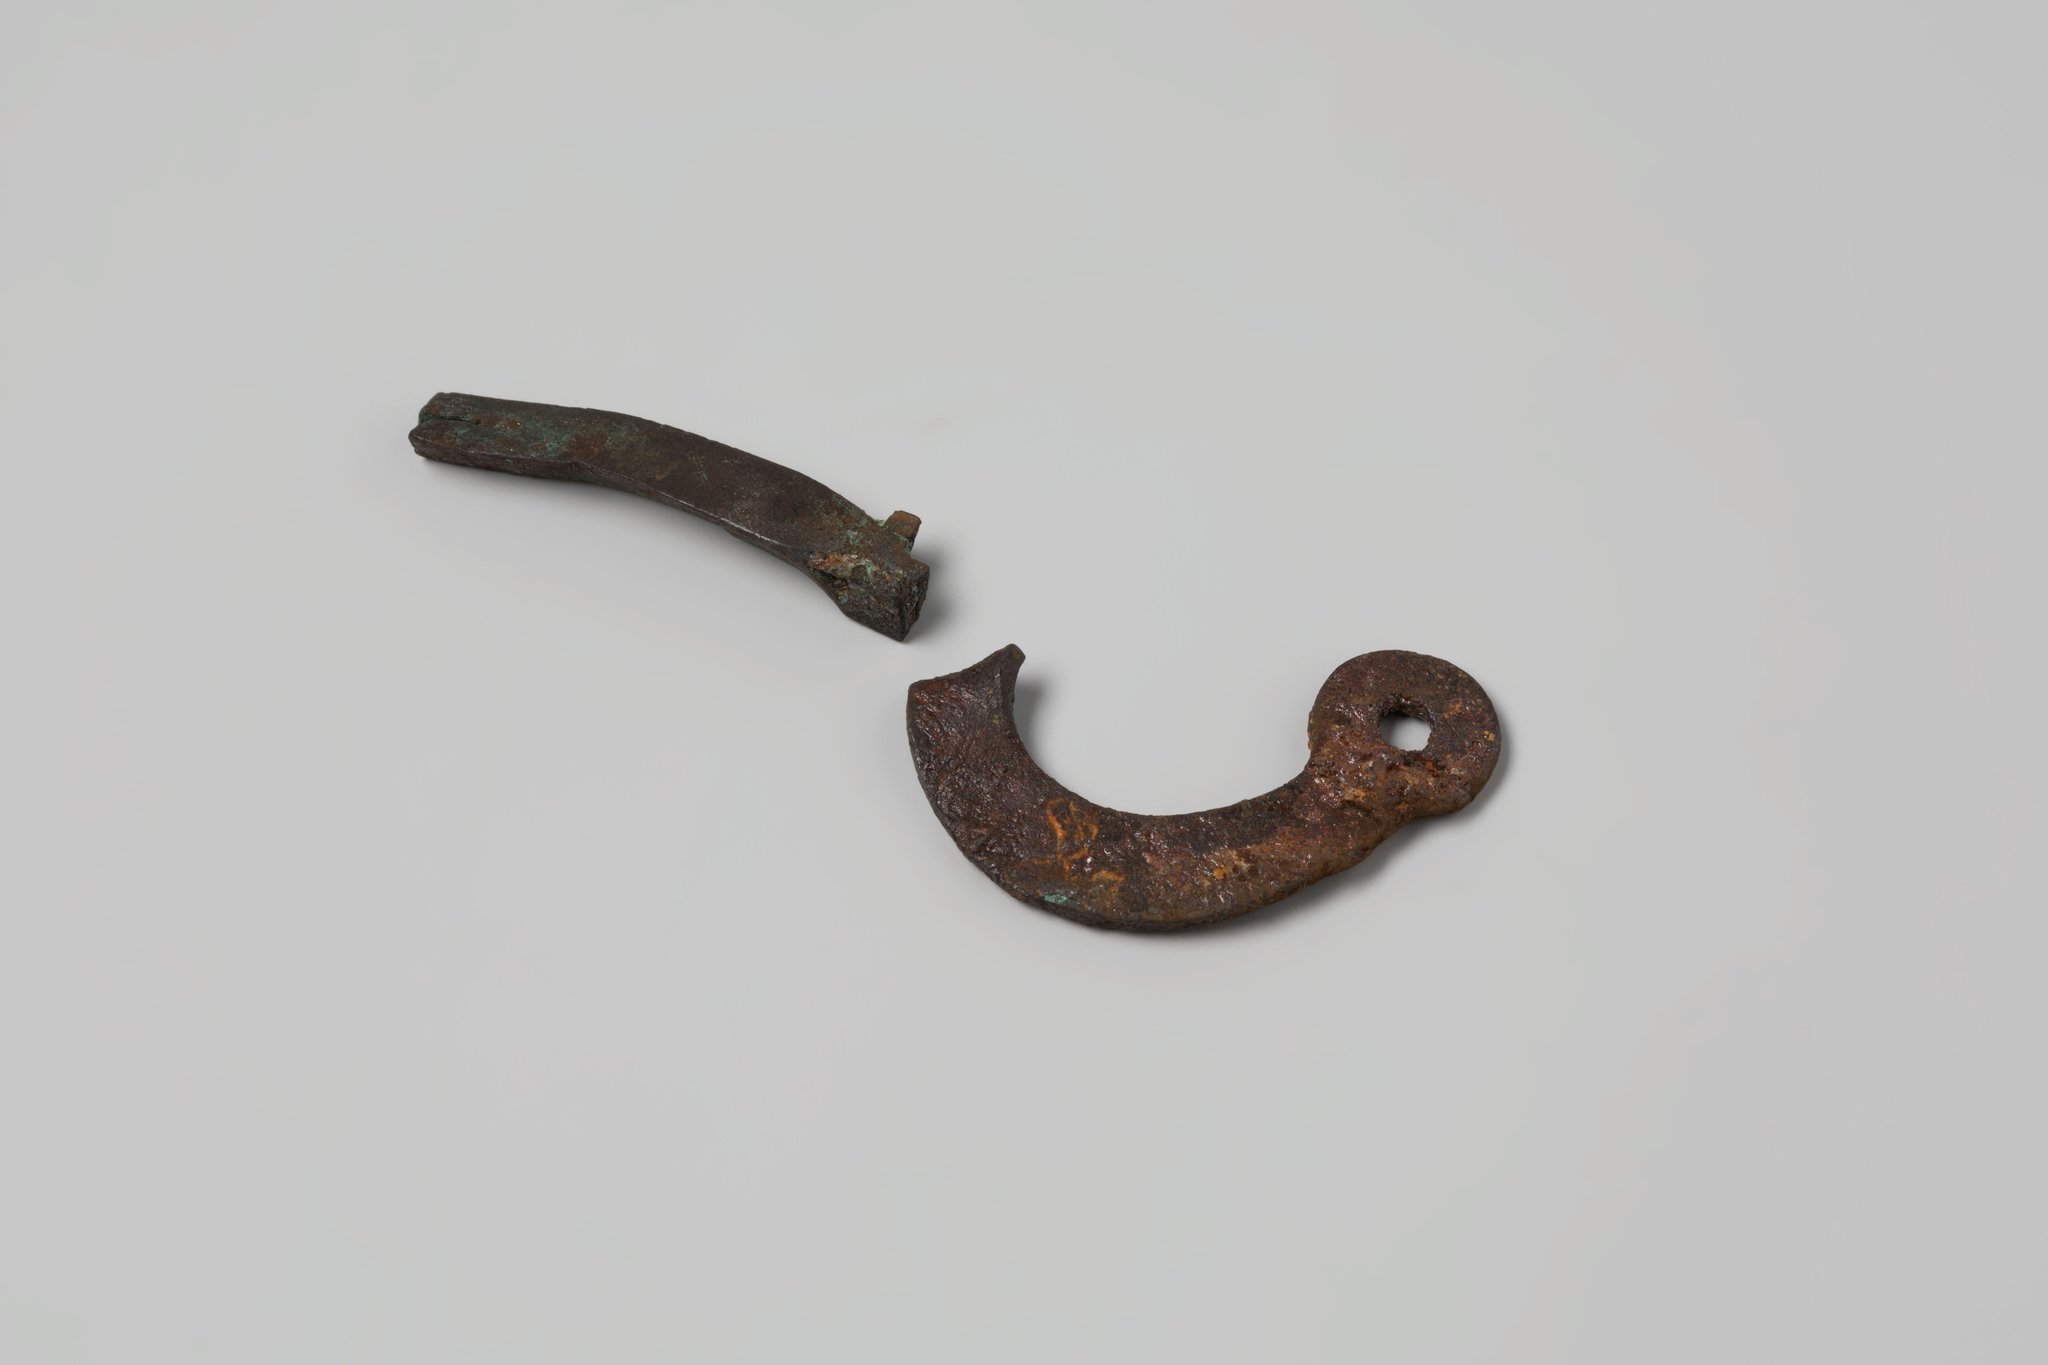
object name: divider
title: Fragmenten steekpasser uit het wrak van de Oost-Indiëvaarder Hollandia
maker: Anonymous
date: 1700-1743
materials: copper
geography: netherlands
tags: verenigde oostindische compagnie, hollandia (schip), annet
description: Divider; fragments: semicircular ring id. NG 1980-27H1669: leg id. NG 1980-27H1171.